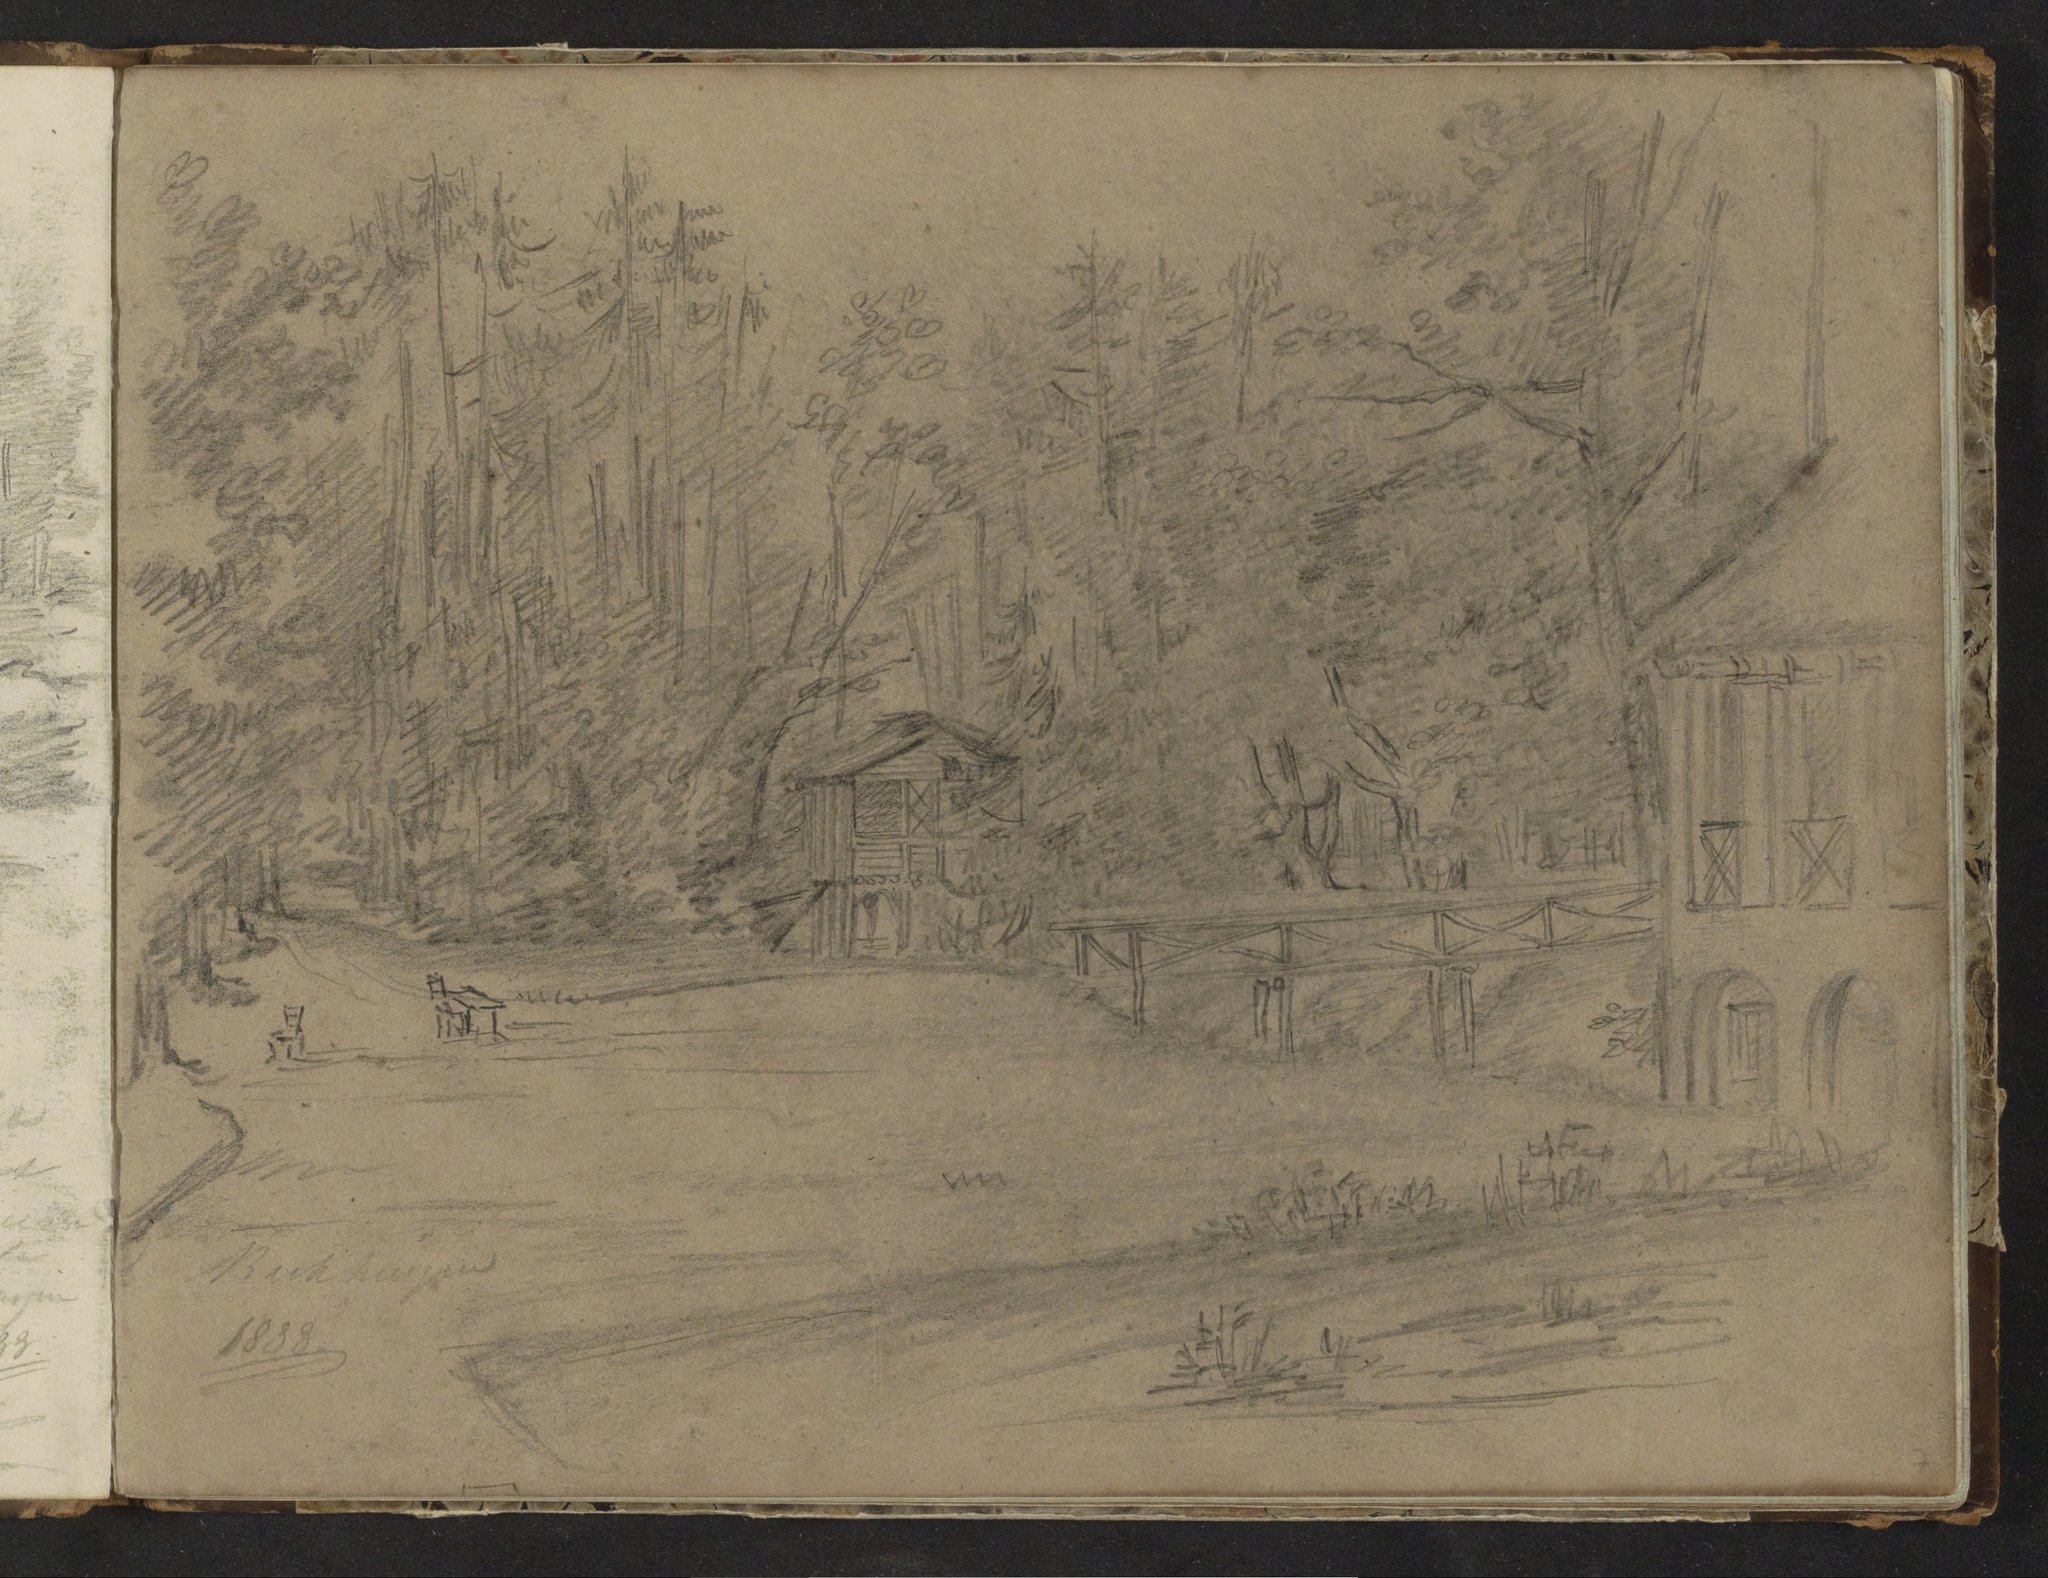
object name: sketchbook leaf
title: Huis met een brug op het landgoed Beekhuizen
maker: johannes tavenraat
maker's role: draughtsman, painter, print maker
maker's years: 1809-1881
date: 1833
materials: paper, pencil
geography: gelderland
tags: park, forest, wood, forest path or lane, architecture, bridge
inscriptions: date and inscription: ‘Beekhuizen/ 1833.’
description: Mogelijk Hotel Beekhuizen. Blad 7 recto uit een schetsboek met 41 bladen.